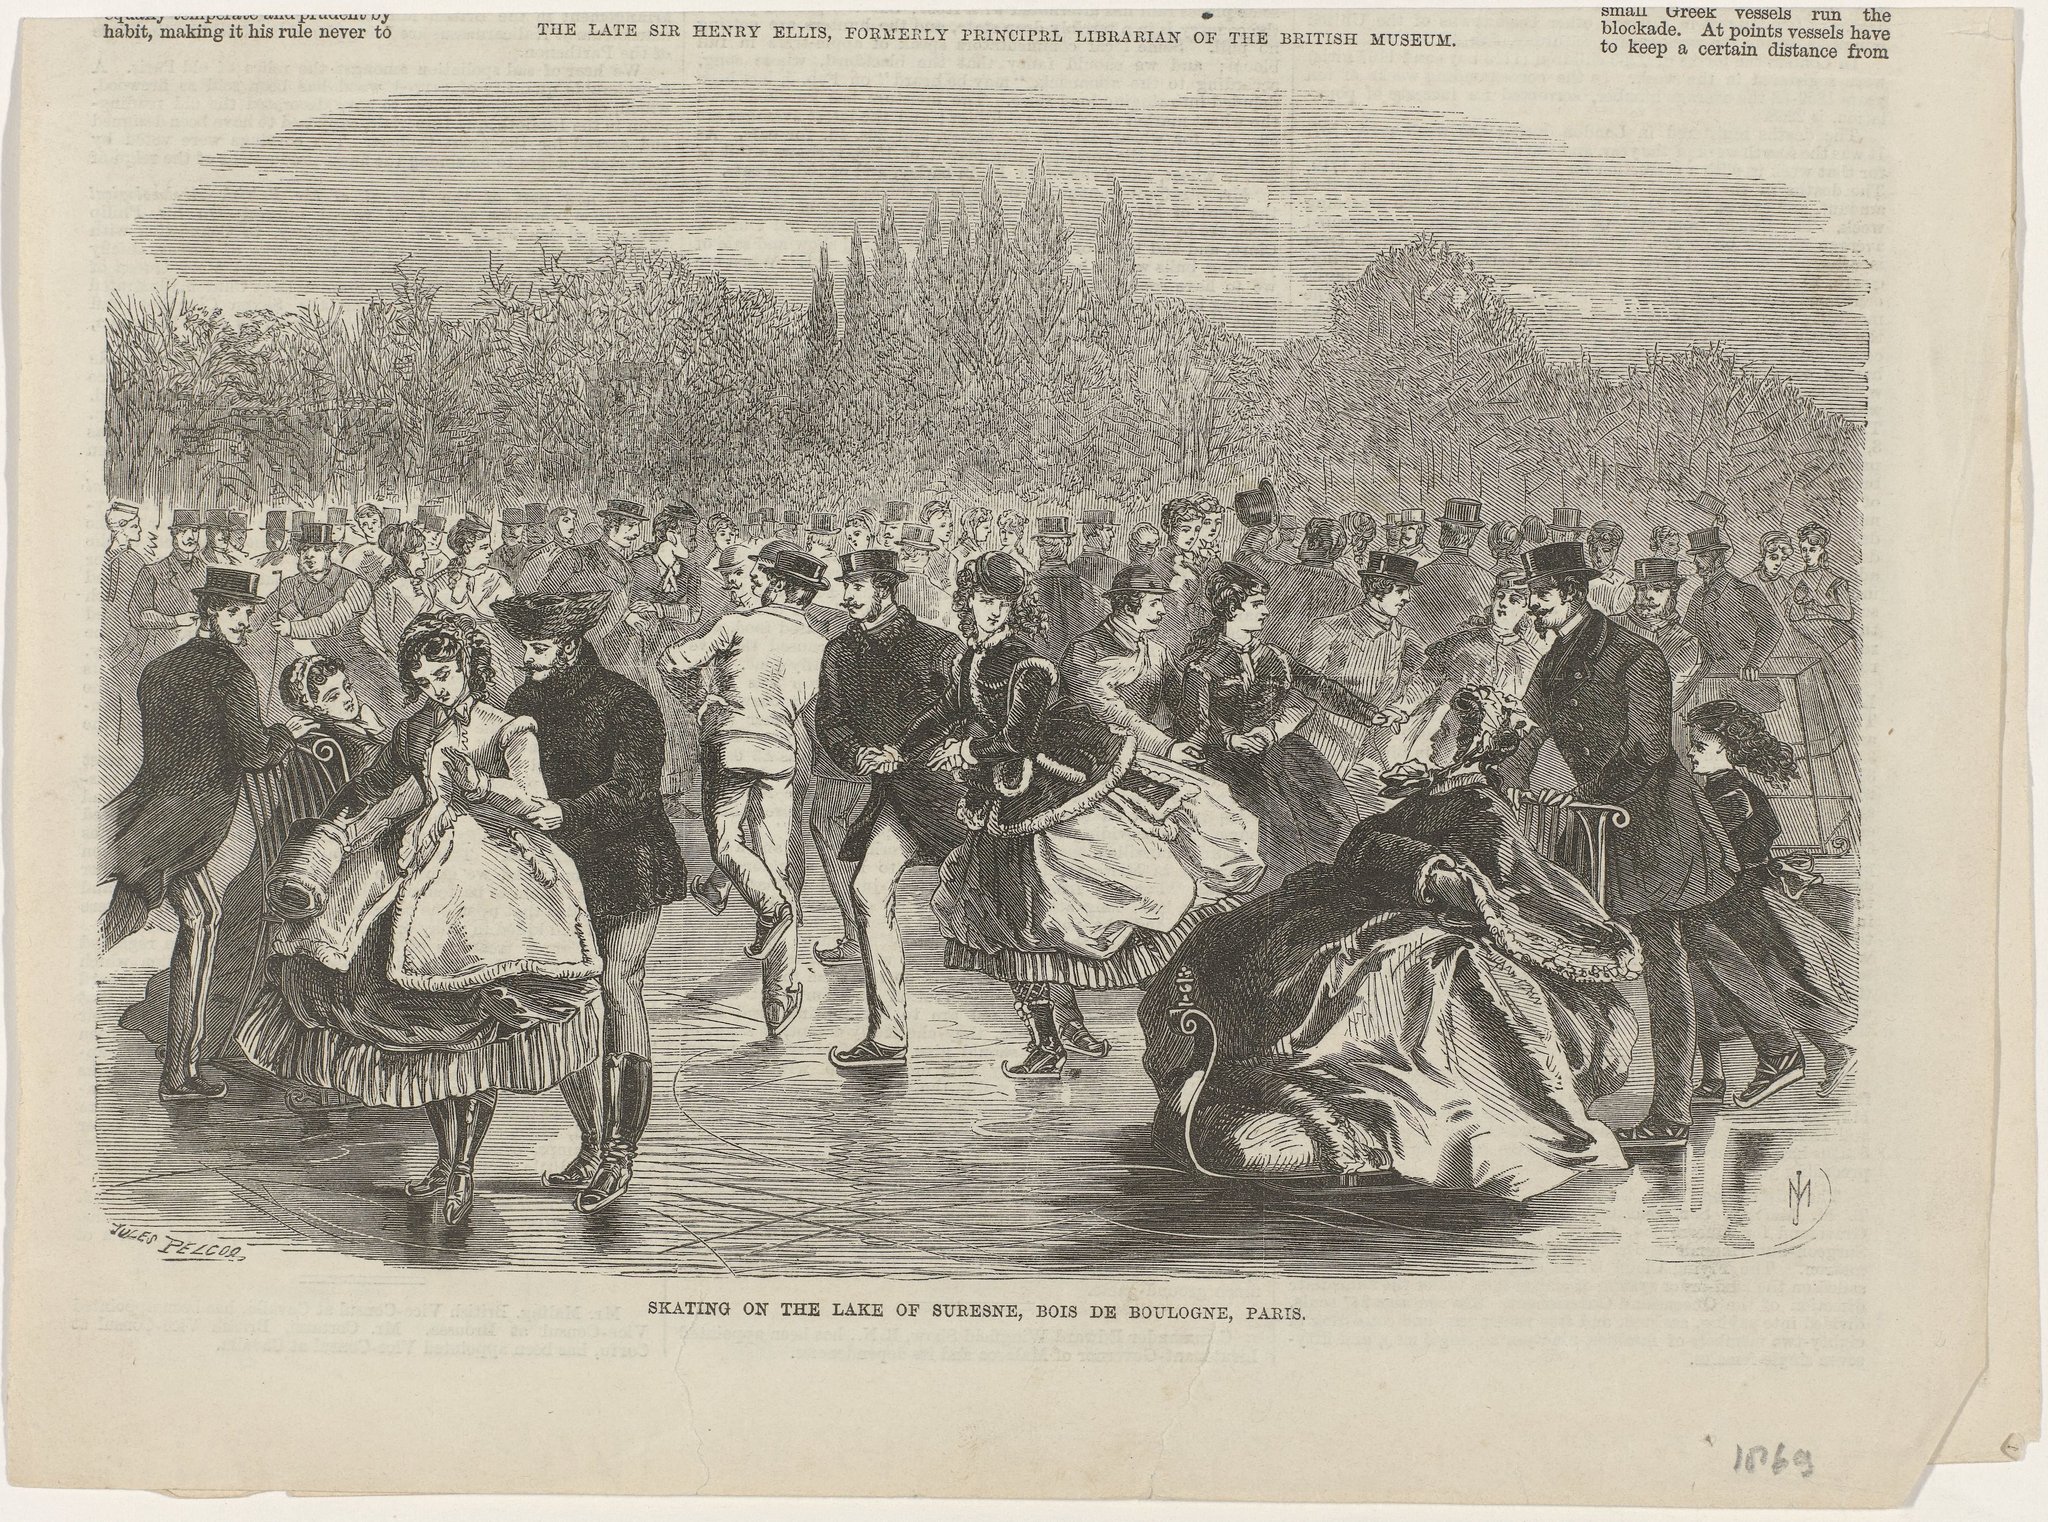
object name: fashion print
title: The Illustrated London News, Supplement, 6 Feb. 1869 : Skating on the lake of Suresn (...)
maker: jules pelcoq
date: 1869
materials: paper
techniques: engraving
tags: couple of lovers (+ variant), coat (+ women's clothes), fashion plates, skirt (+ women's clothes), skates (winter sports), sledge, sleigh (winter sports), muff (+ fur used for clothes), historical persons (portraits and scenes from the life)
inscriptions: title: ‘THE ILLUSTRATED LONDON NEWS’, caption: ‘THE LATE SIR HENRY ELLIS, FORMELY PRINCIPRL LIBRARIAN OF THE BRITISH MUSEUM. / SKATING ON THE LAKE OF SURESNE, BOIS DE BOULOGNE, PARIS.’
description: Boven: portret van de overleden Sir Henry Ellis, senior bibliothecaris van het British Museum. Onder: een grote groep mensen schaatsen op het ijs van het meer van Suresne, Bois de Boulogne, Parijs.